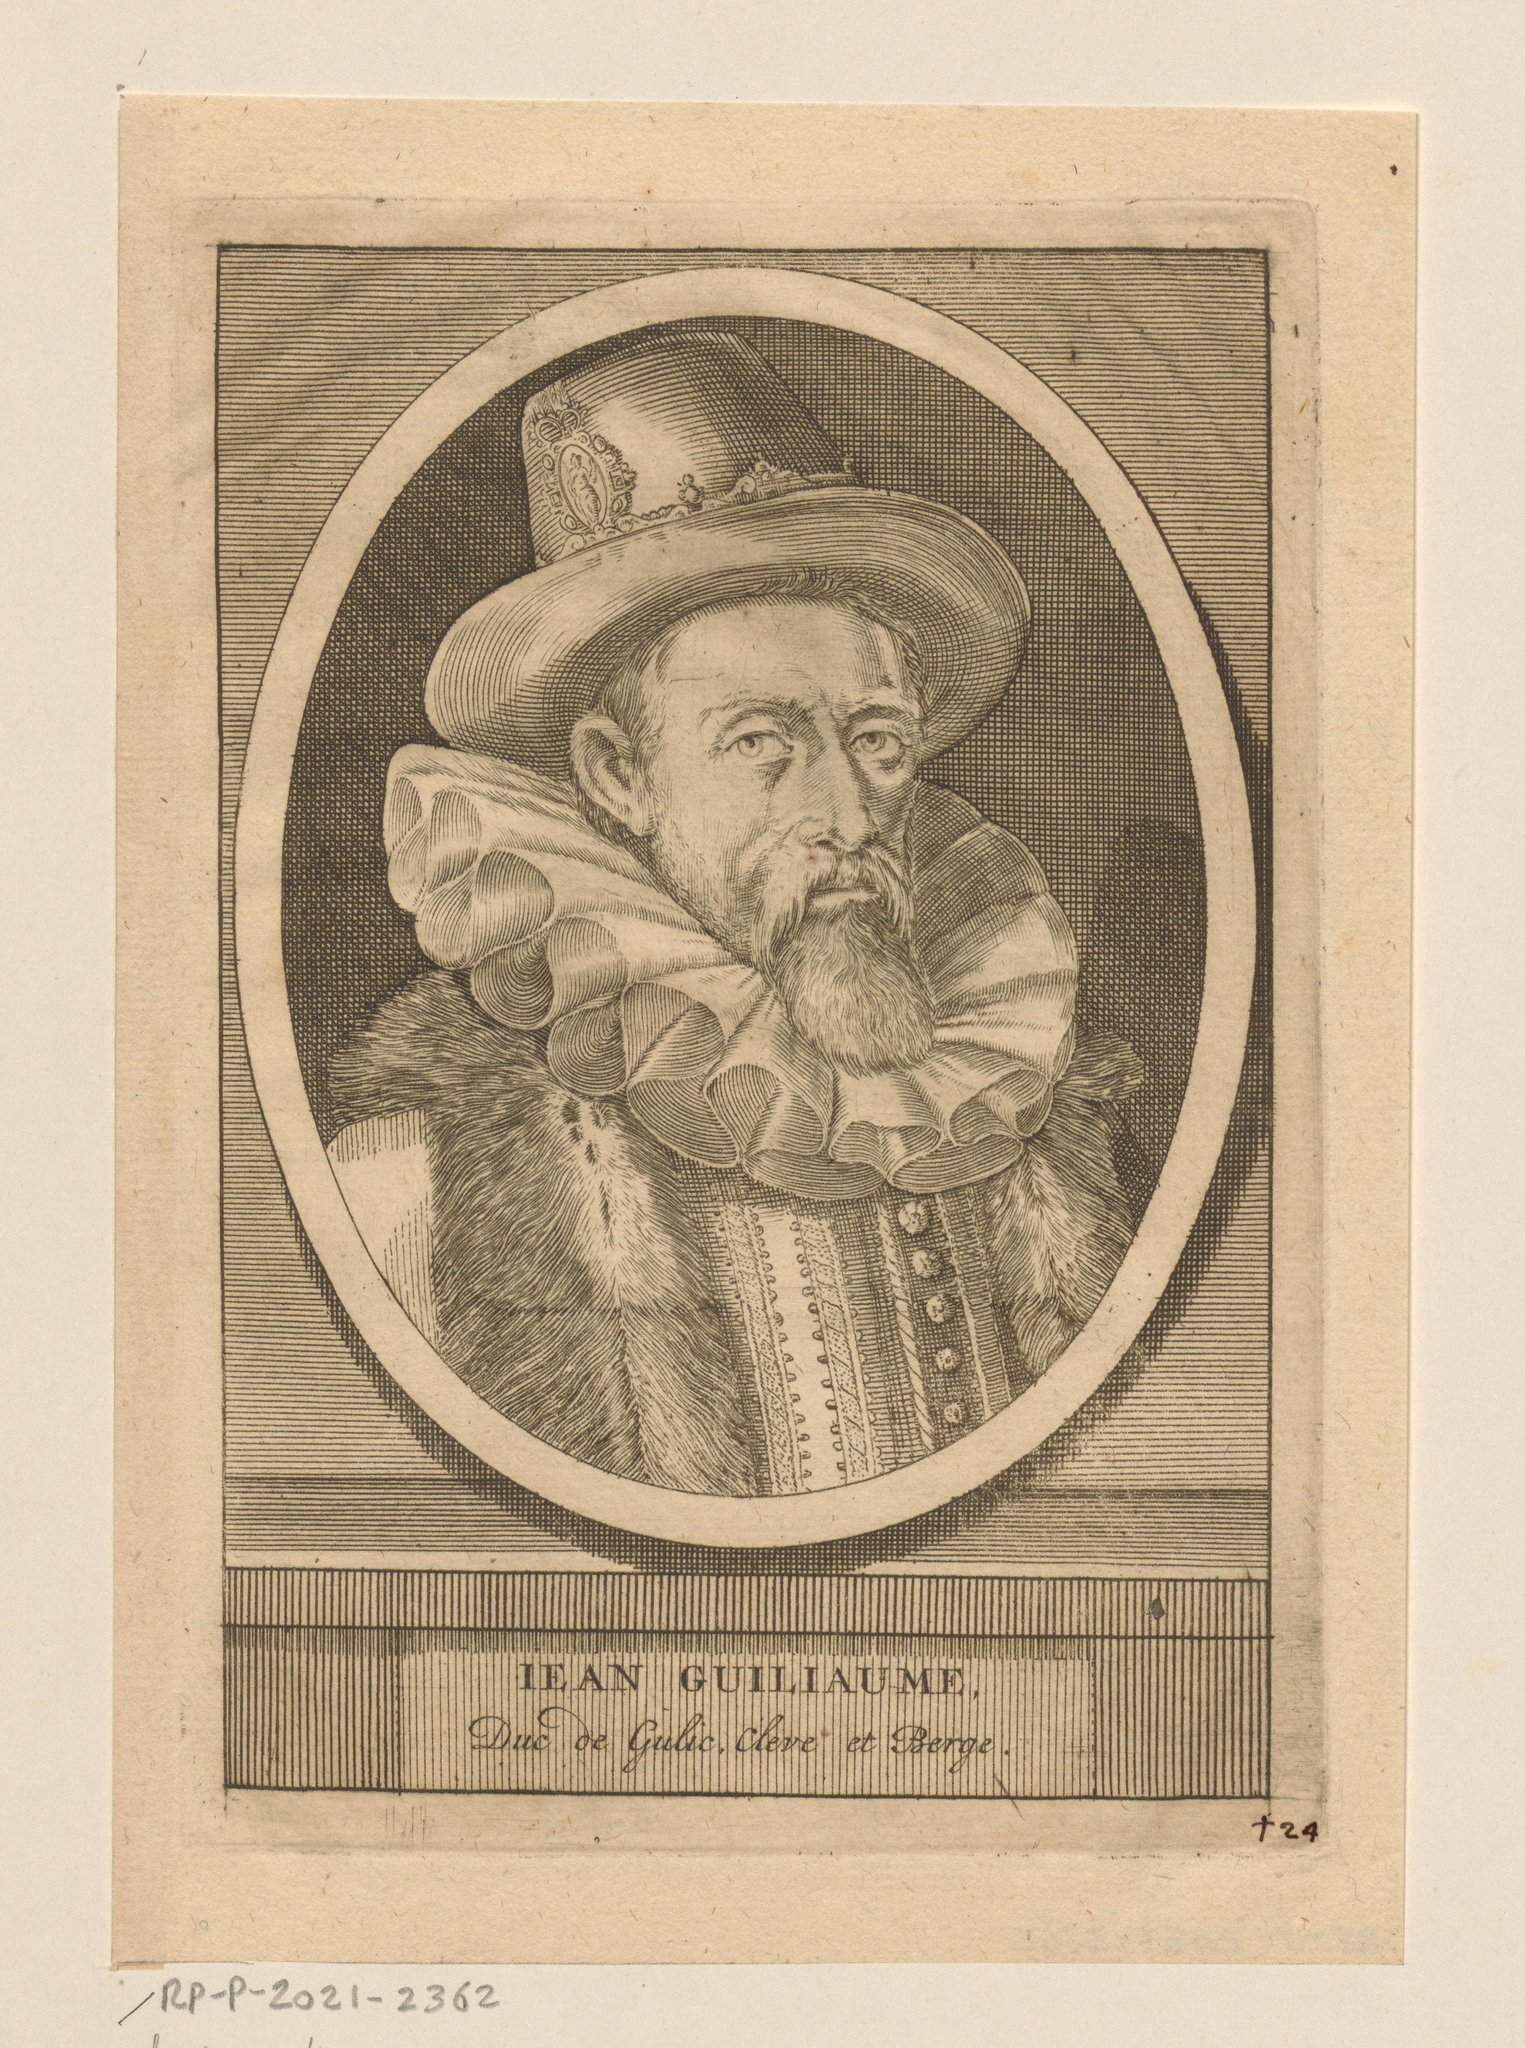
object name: print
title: Portret van Johan Willem van Kleef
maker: Anonymous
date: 1700-1799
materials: paper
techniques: engraving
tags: archbishop, bishop, etc. (roman catholic), historical persons, social stratification, social groups, head-gear: hat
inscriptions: inscription: ‘+24’